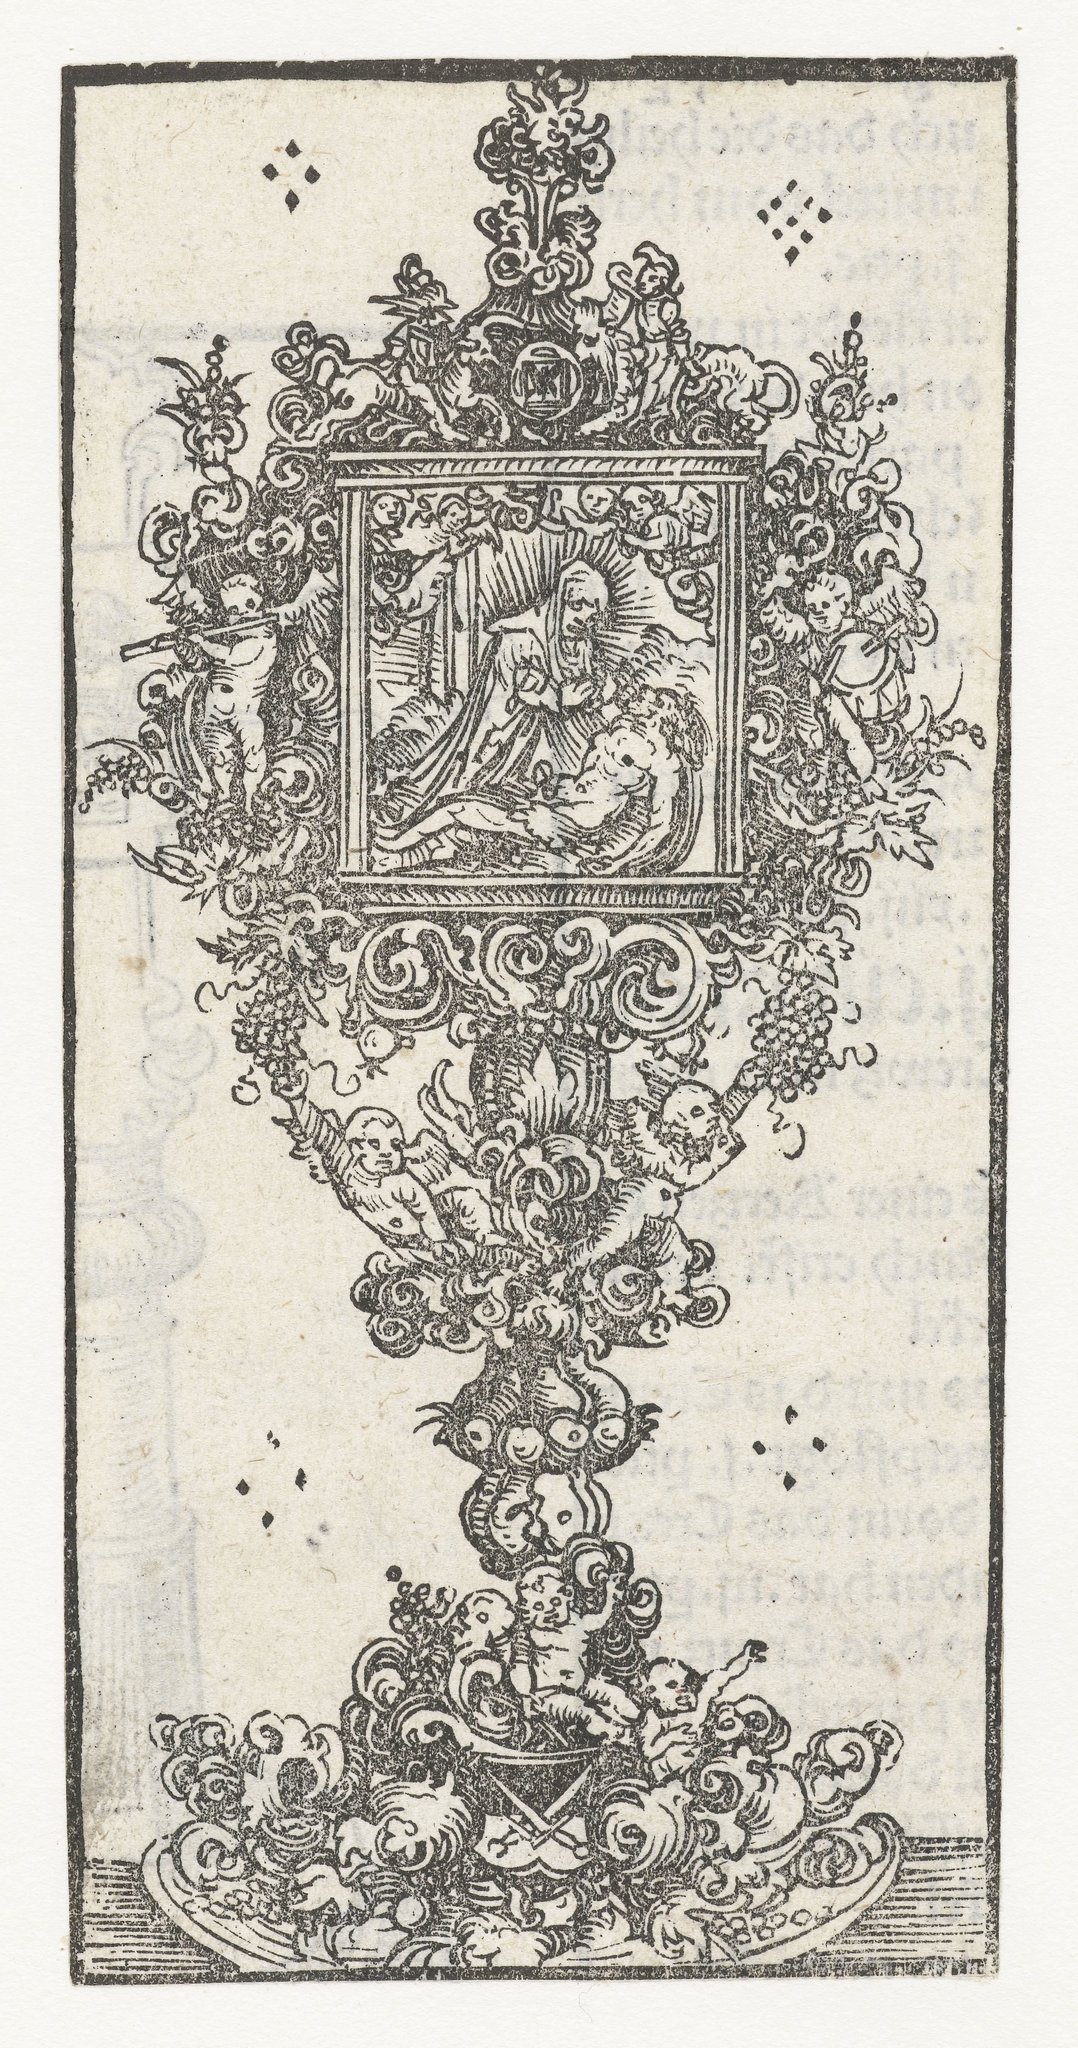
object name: print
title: Reliekhouder met de bewening van Christus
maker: lucas cranach (i)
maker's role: draughtsman, print maker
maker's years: 1472-1553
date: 1509-1549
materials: paper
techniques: woodcut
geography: wittenberg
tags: 'pietà ', 'vesperbild', 'marienklage' (no others present): christ, either with or without crown of thorns, mourned by mary, relics (and reliquaries)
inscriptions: collector's mark: Lugt 240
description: De houtblokken werden in 1509 voor het eerst gebruikt in: Dye zaigung des hochlobwirdigen hailigthums der Stiftkirchen allerhailigen zu wittenburg, Wittenberg, Symphorian Reinhart. Daarna volgden verschillende uitgaven van de Hortulus Animae (uitgever Georg Rhau) waarin de blokken opnieuw gebruikt werden.